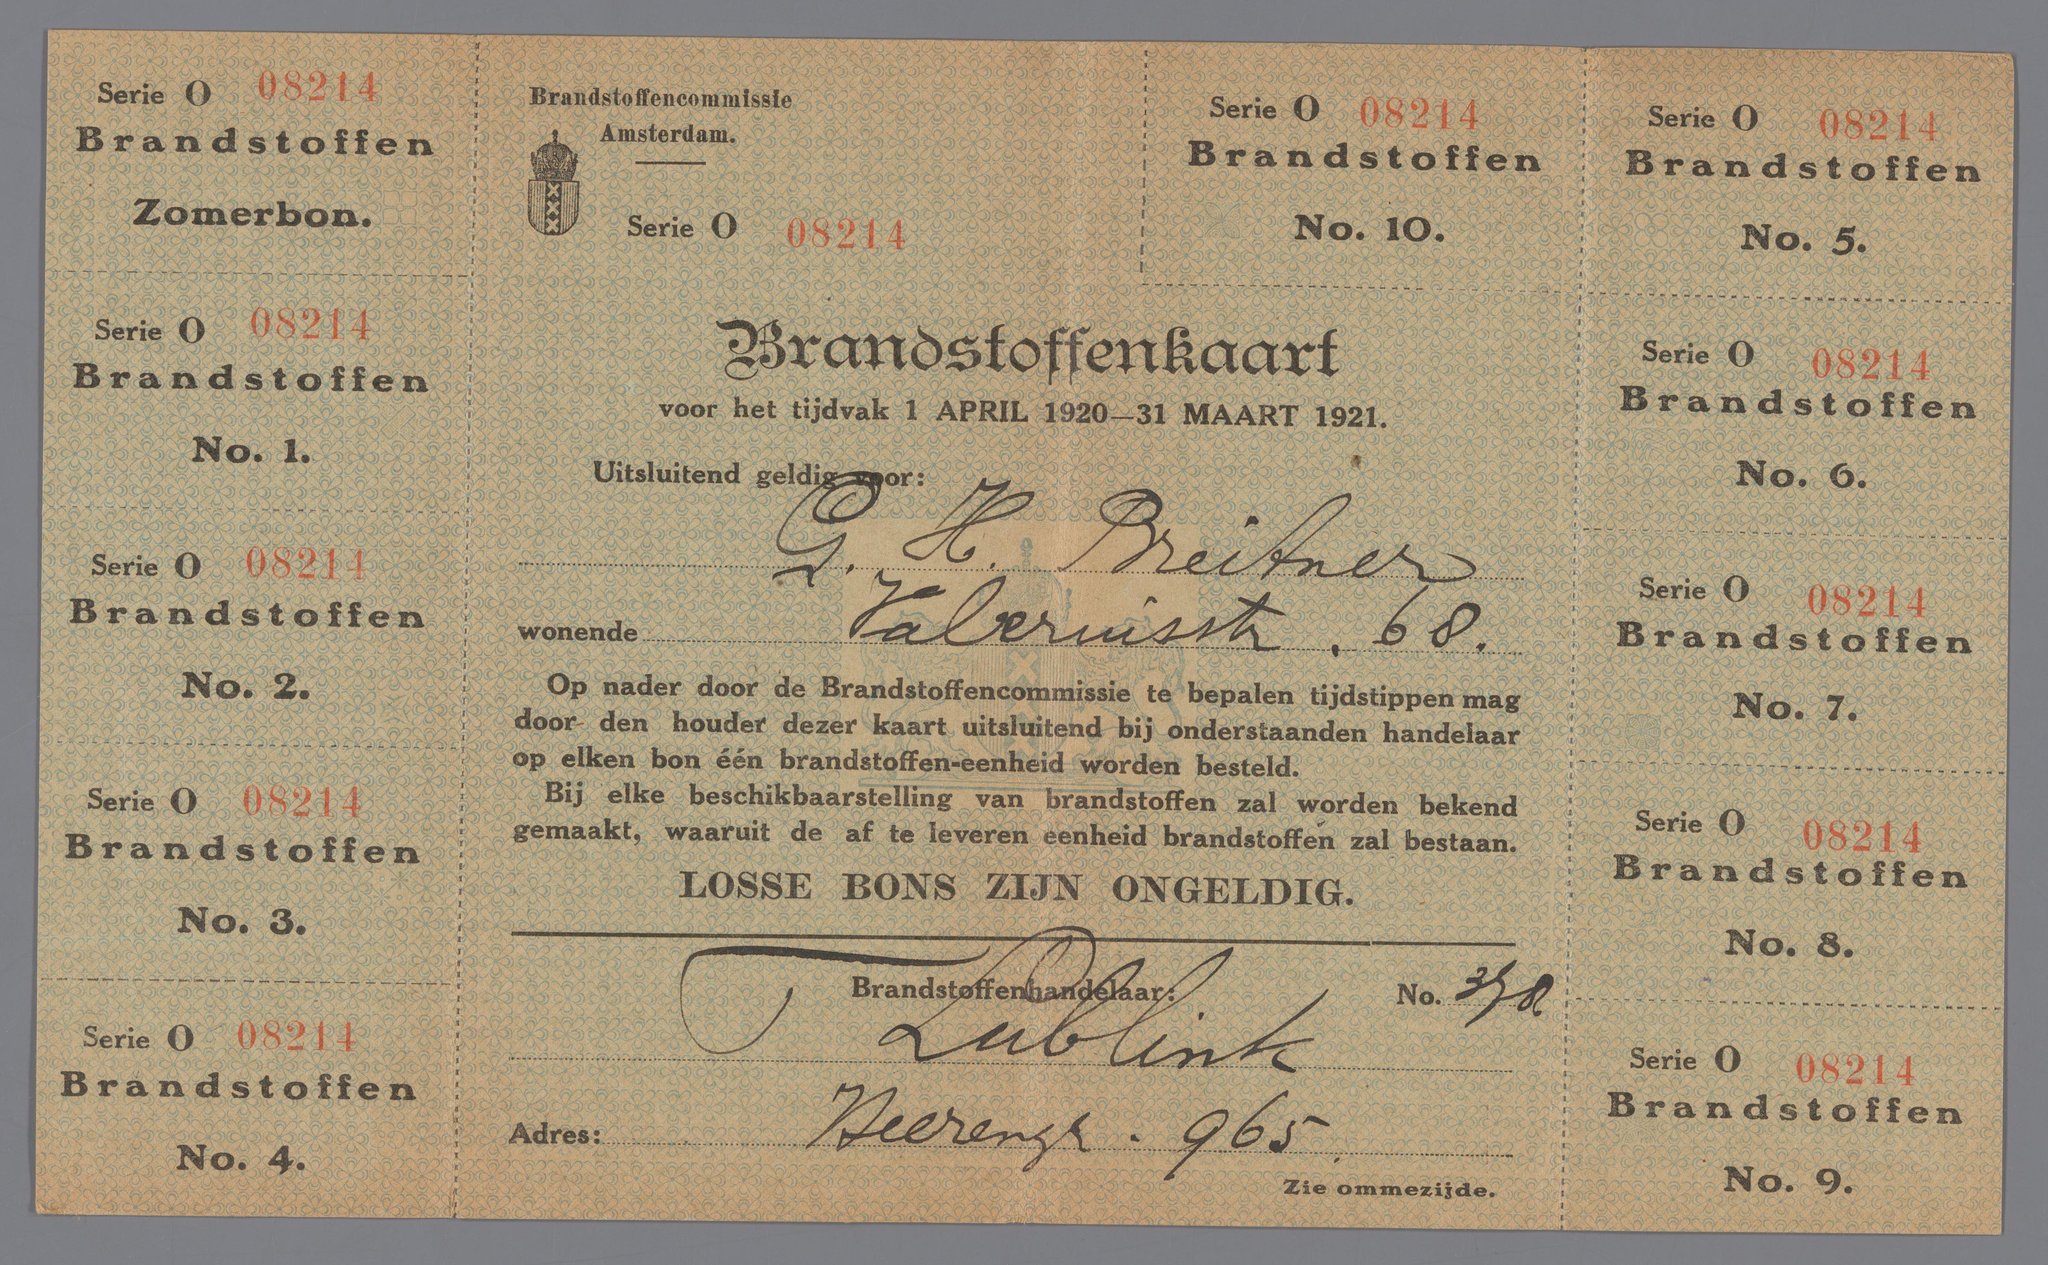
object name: voucher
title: Verschillende soorten distributiebonnen behorende tot George Hendrik Breitner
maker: Anonymous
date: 1921-1922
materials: cardboard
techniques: printing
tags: rotterdam, painter, print maker, draughtsman, george hendrik breitner, letter, envelope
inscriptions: date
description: 23 verschillende soorten distributiebonnen.